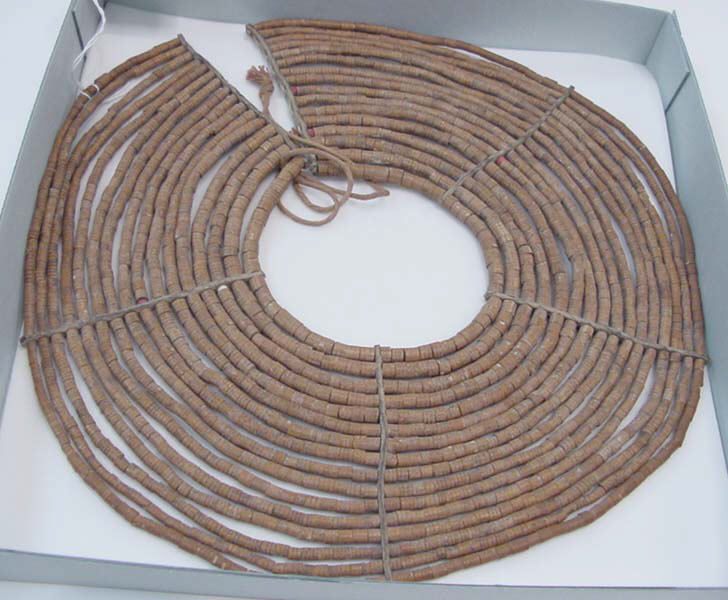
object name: necklace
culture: african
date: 1801-1900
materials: cotton, leather, wood